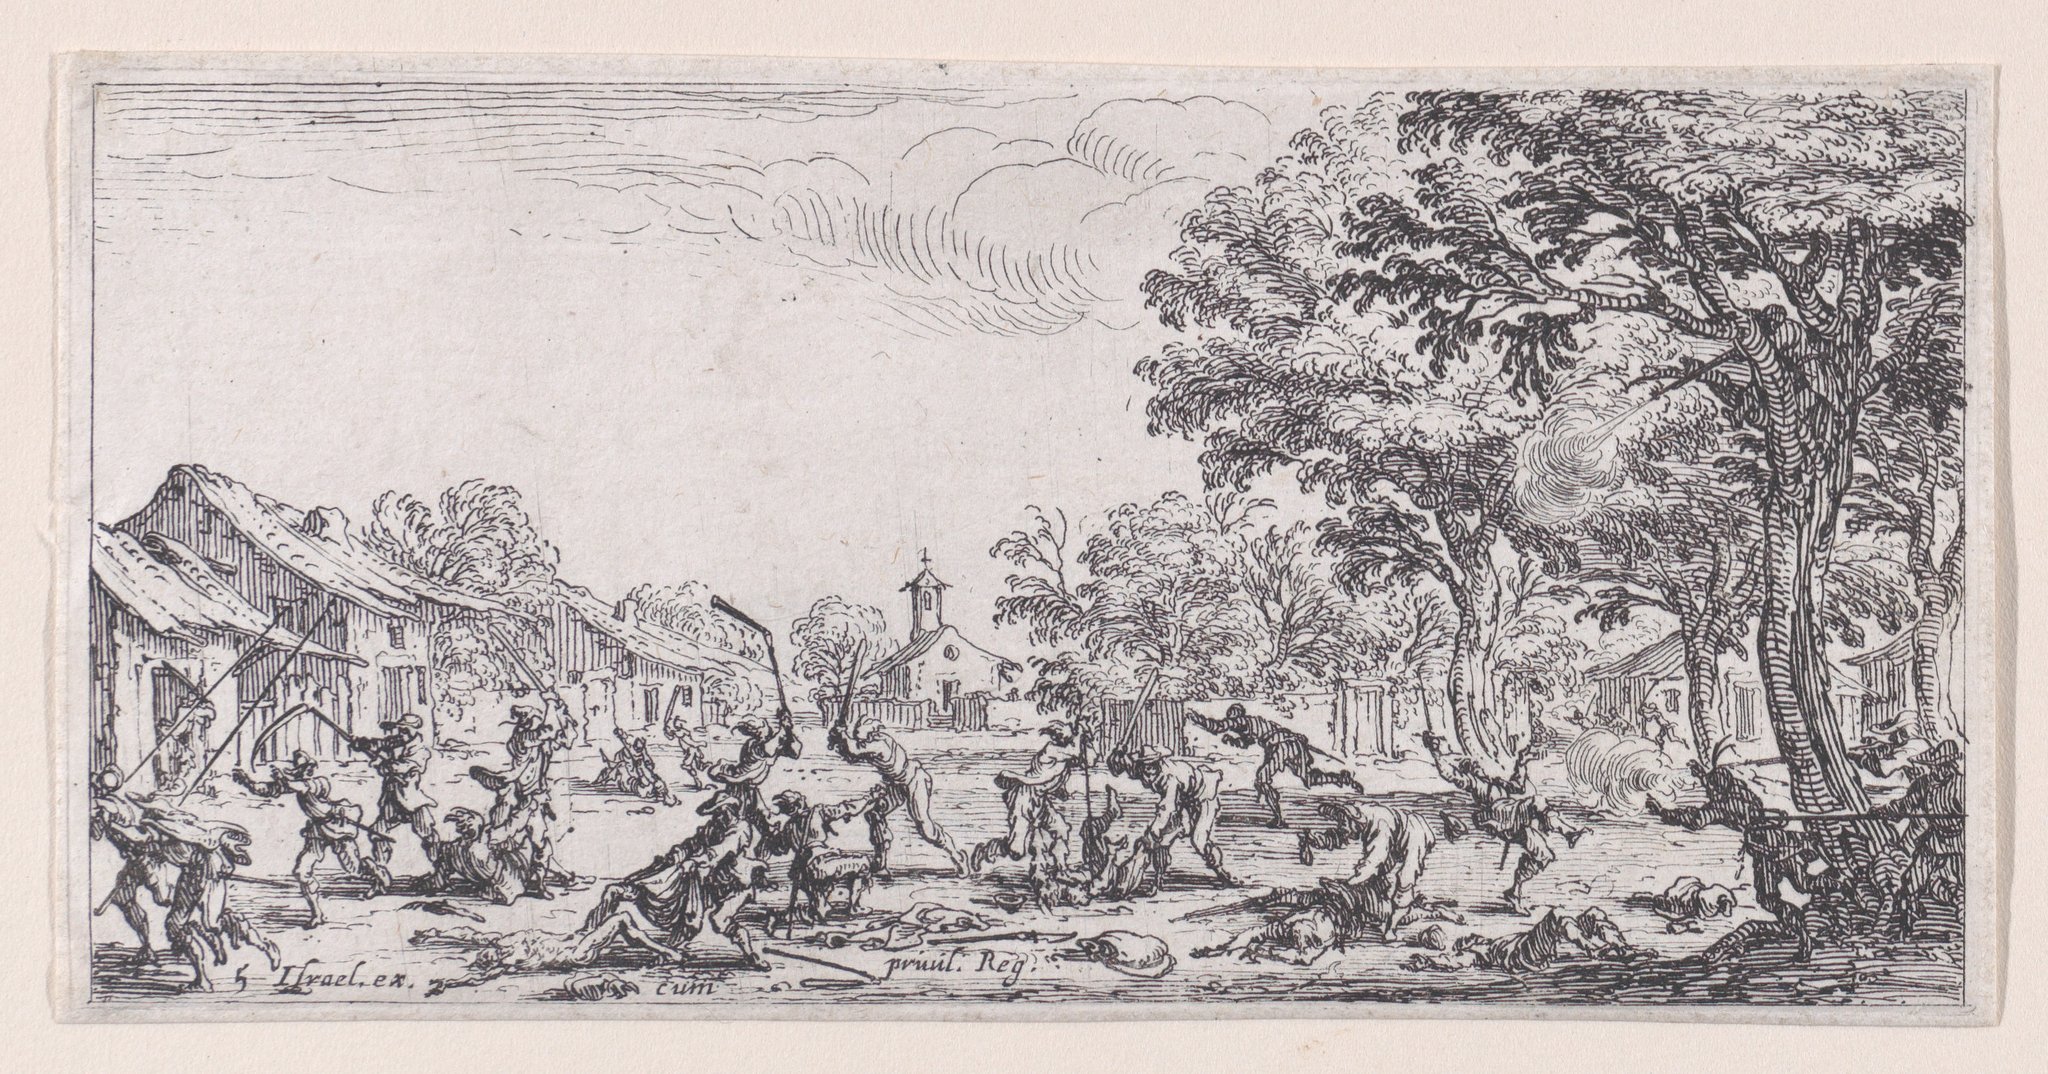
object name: print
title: Le Revanche des Paysans (The Revenge of the Peasants), plate 5 from "Les Petites Misères de la Guerre" (The Little Miseries of War)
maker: jacques callot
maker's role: artist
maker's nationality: french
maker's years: 1592-1635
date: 1636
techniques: etching